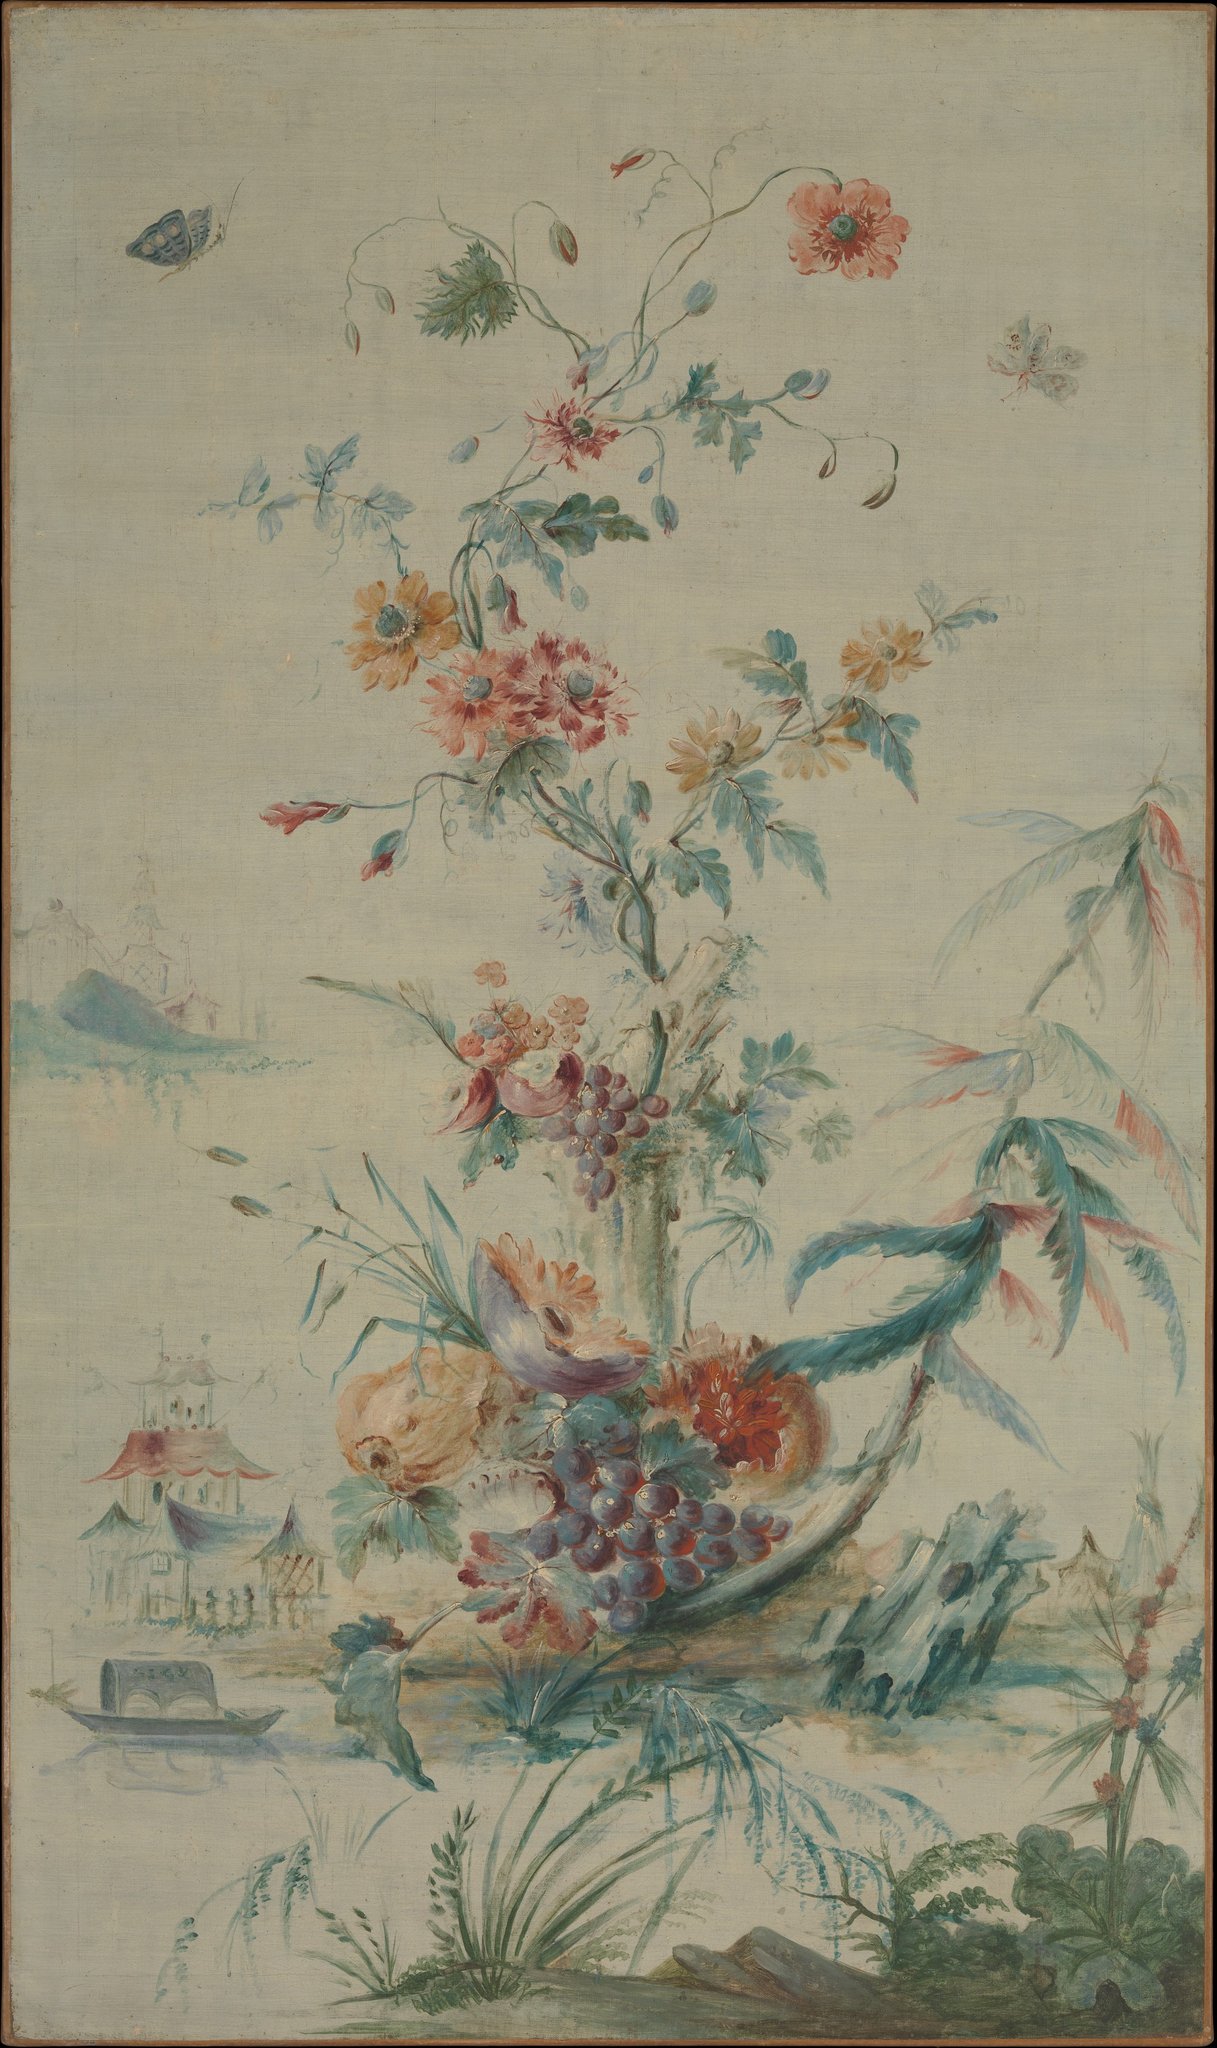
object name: decorative painting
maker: french painter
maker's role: artist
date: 1767-1800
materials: canvas, oil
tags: chinoiserie,grapes,flowers,boats